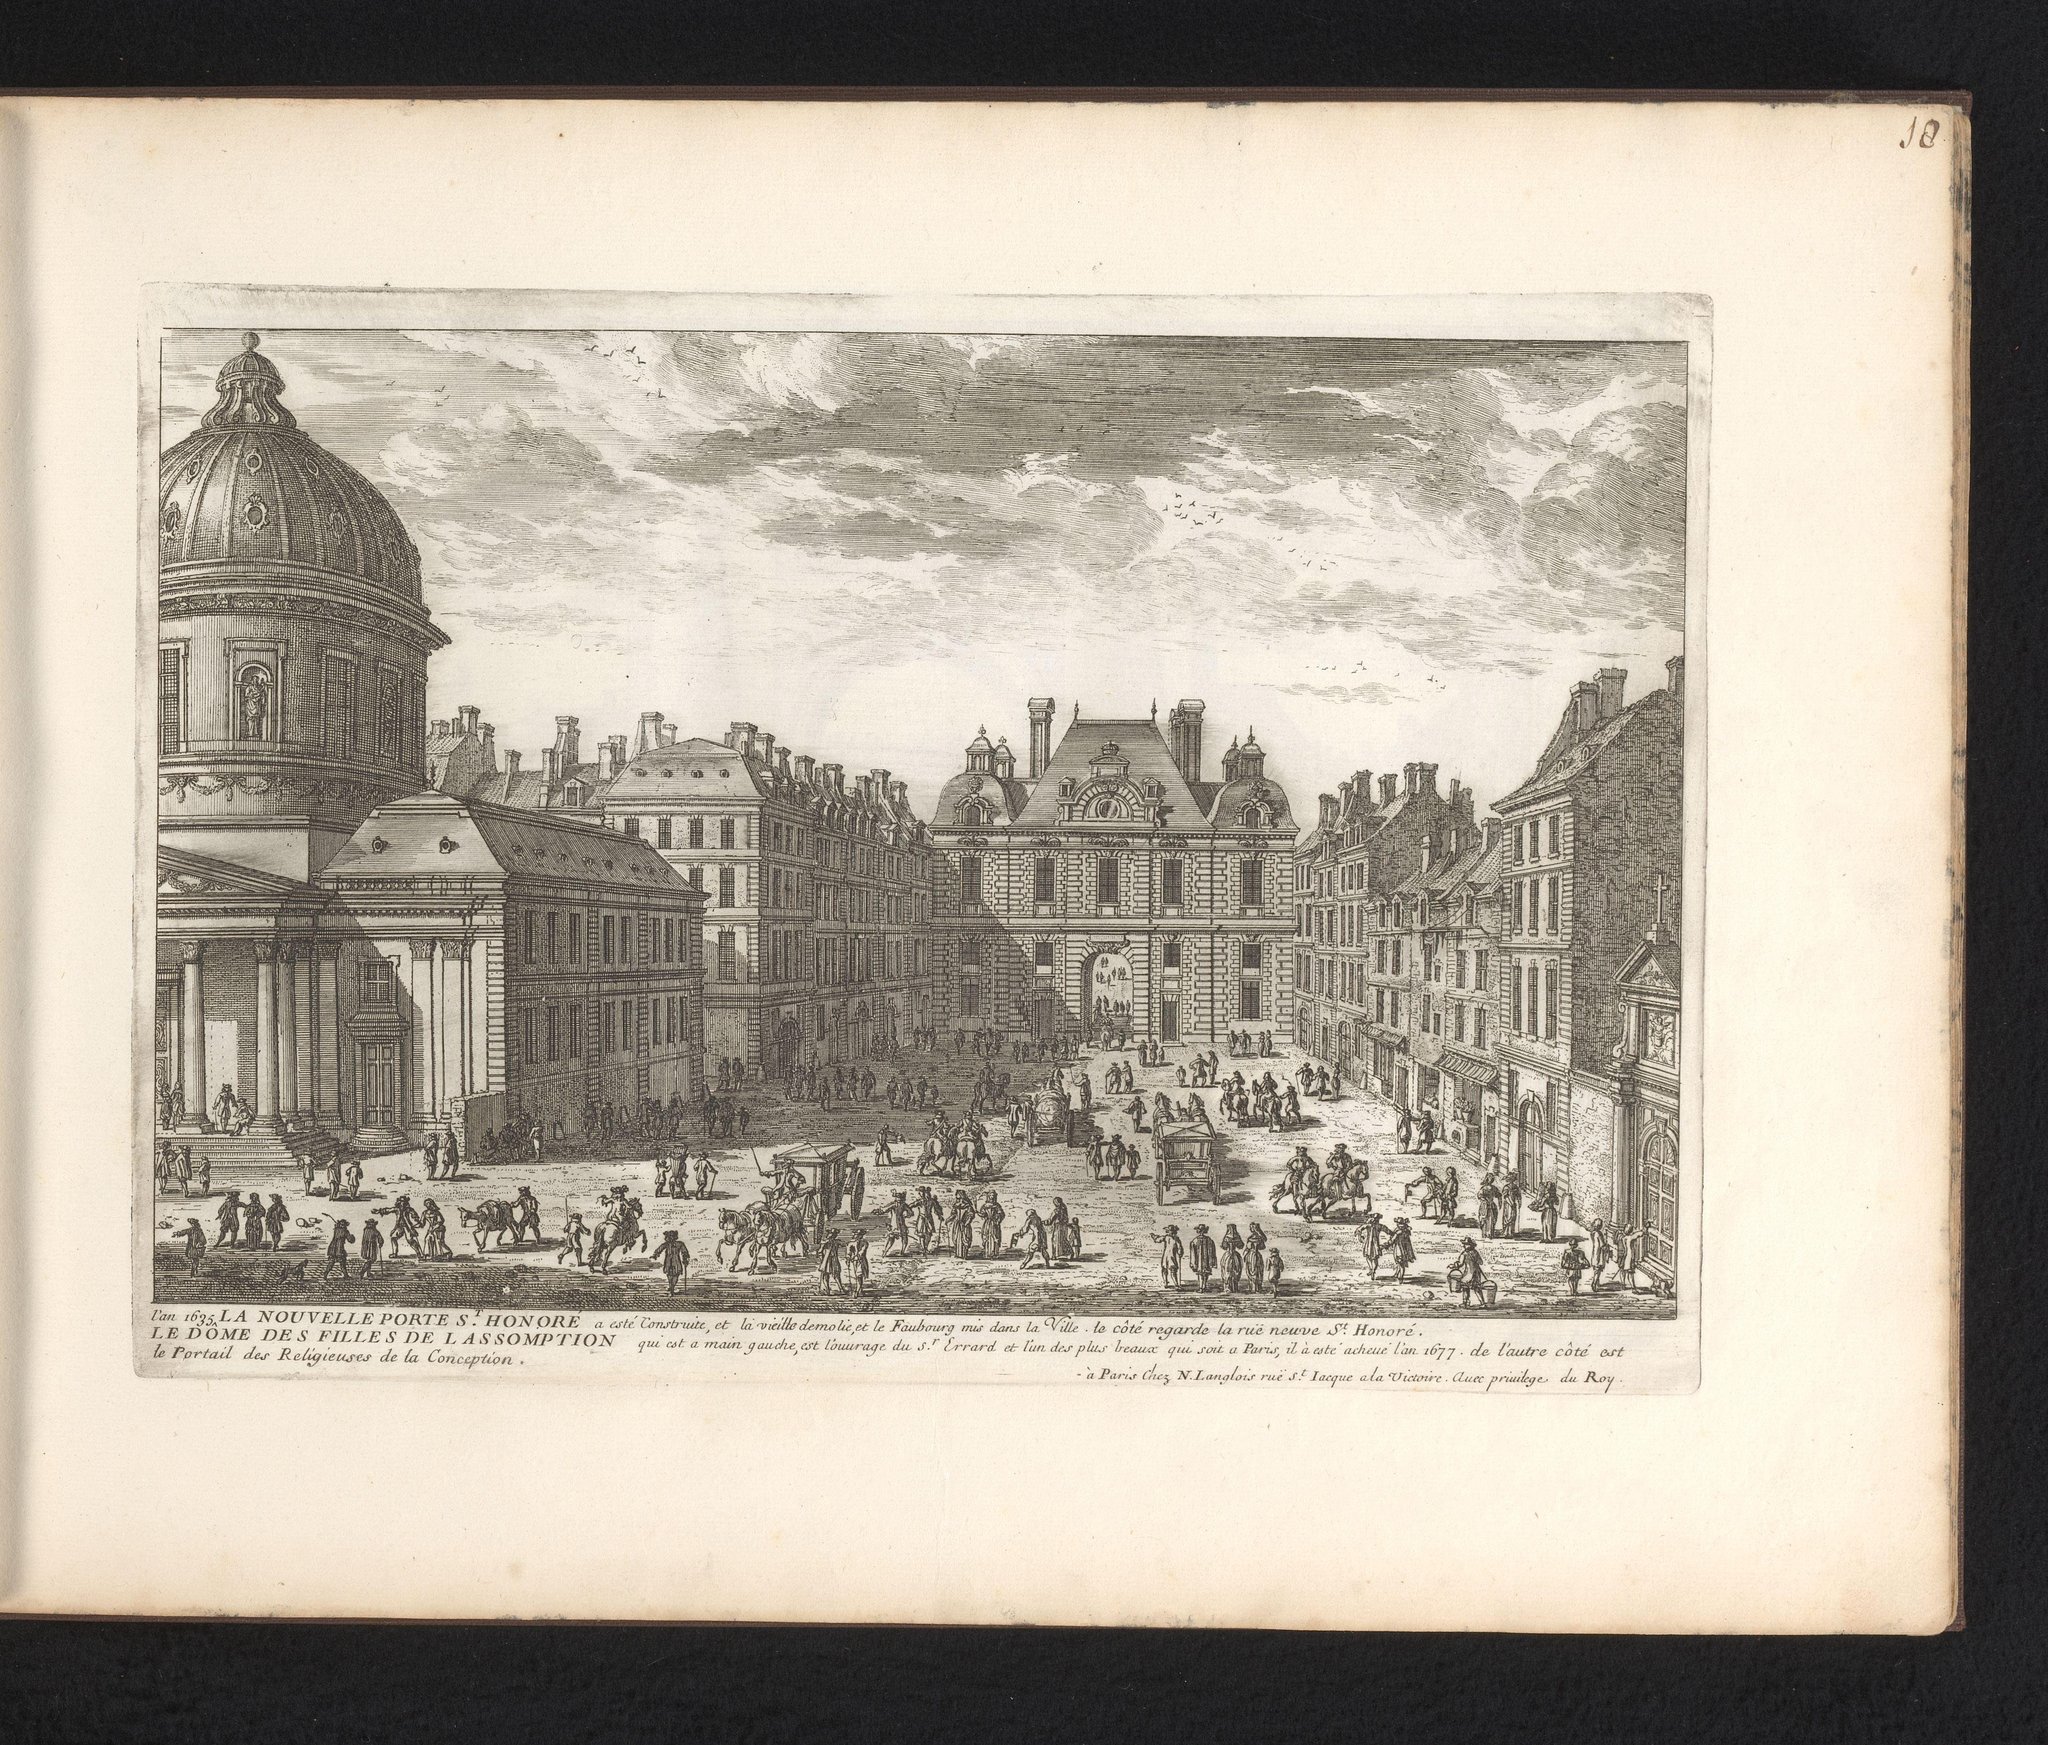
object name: print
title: Stadsgezichten en landschappen in Frankrijk en Italië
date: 1677-1695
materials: paper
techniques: etching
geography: paris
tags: city-gate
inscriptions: collector's mark: Lugt 2228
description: Prenten met het signatuur 'Perelle' kunnen zowel door vader Gabriel als door zonen Nicolas en Adam gemaakt zijn. De uitgevers vader en zoon Nicolas Langlois worden allebei vermeld als N. Langlois op hetzelfde adres.